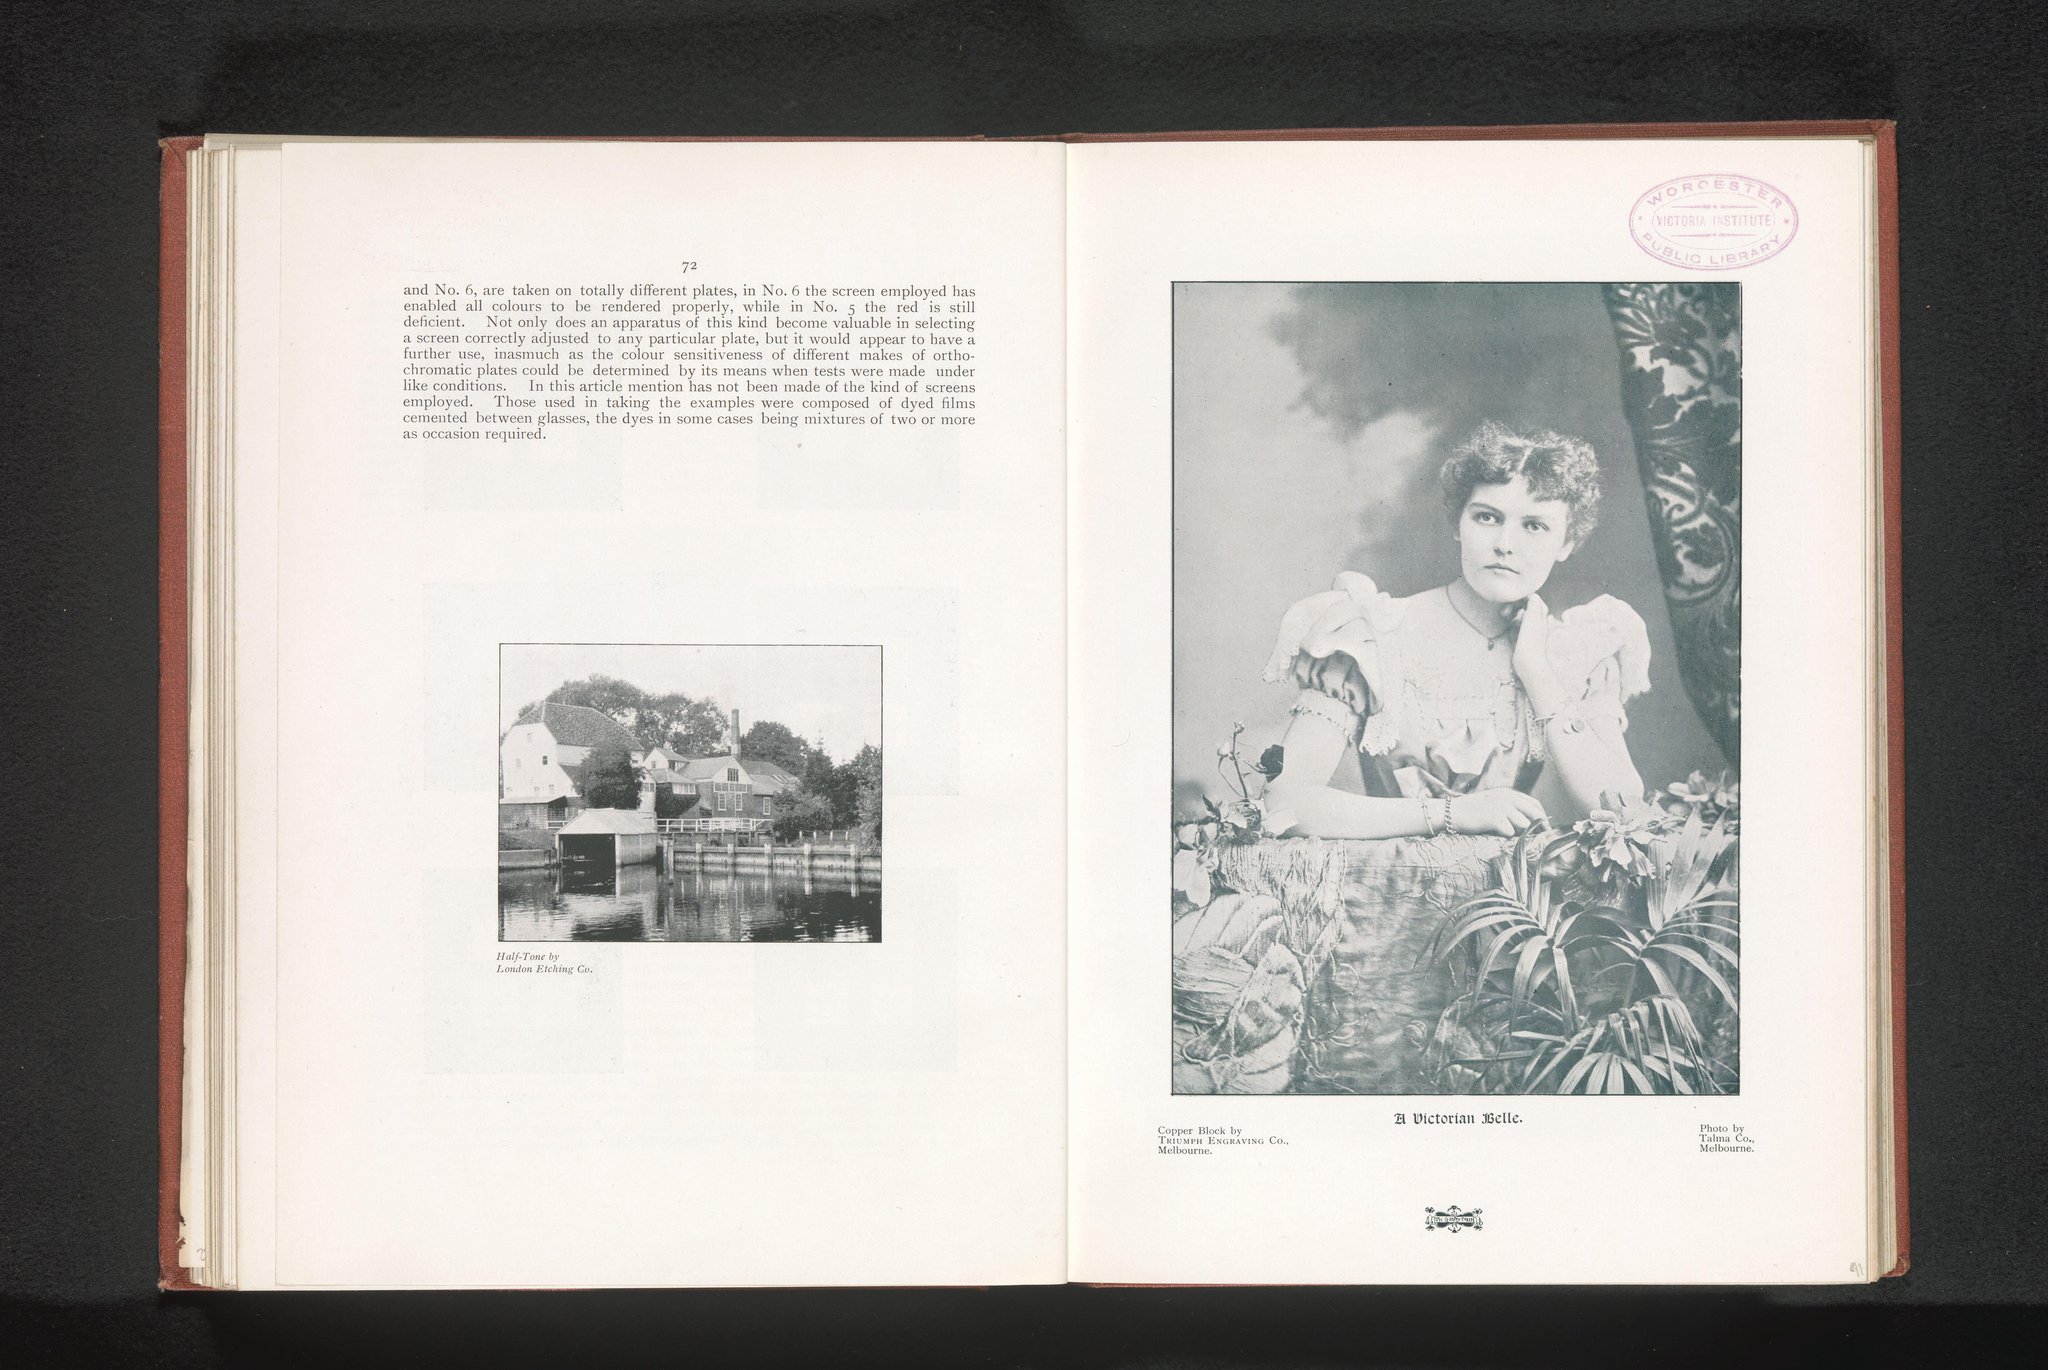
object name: photomechanical print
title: A victorian belle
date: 1895-1900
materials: paper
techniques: autotype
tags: adolescent, young woman, maiden, historical persons - bb - woman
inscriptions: collector's mark: ‘Worcester Public Library/ Victoria Institute’